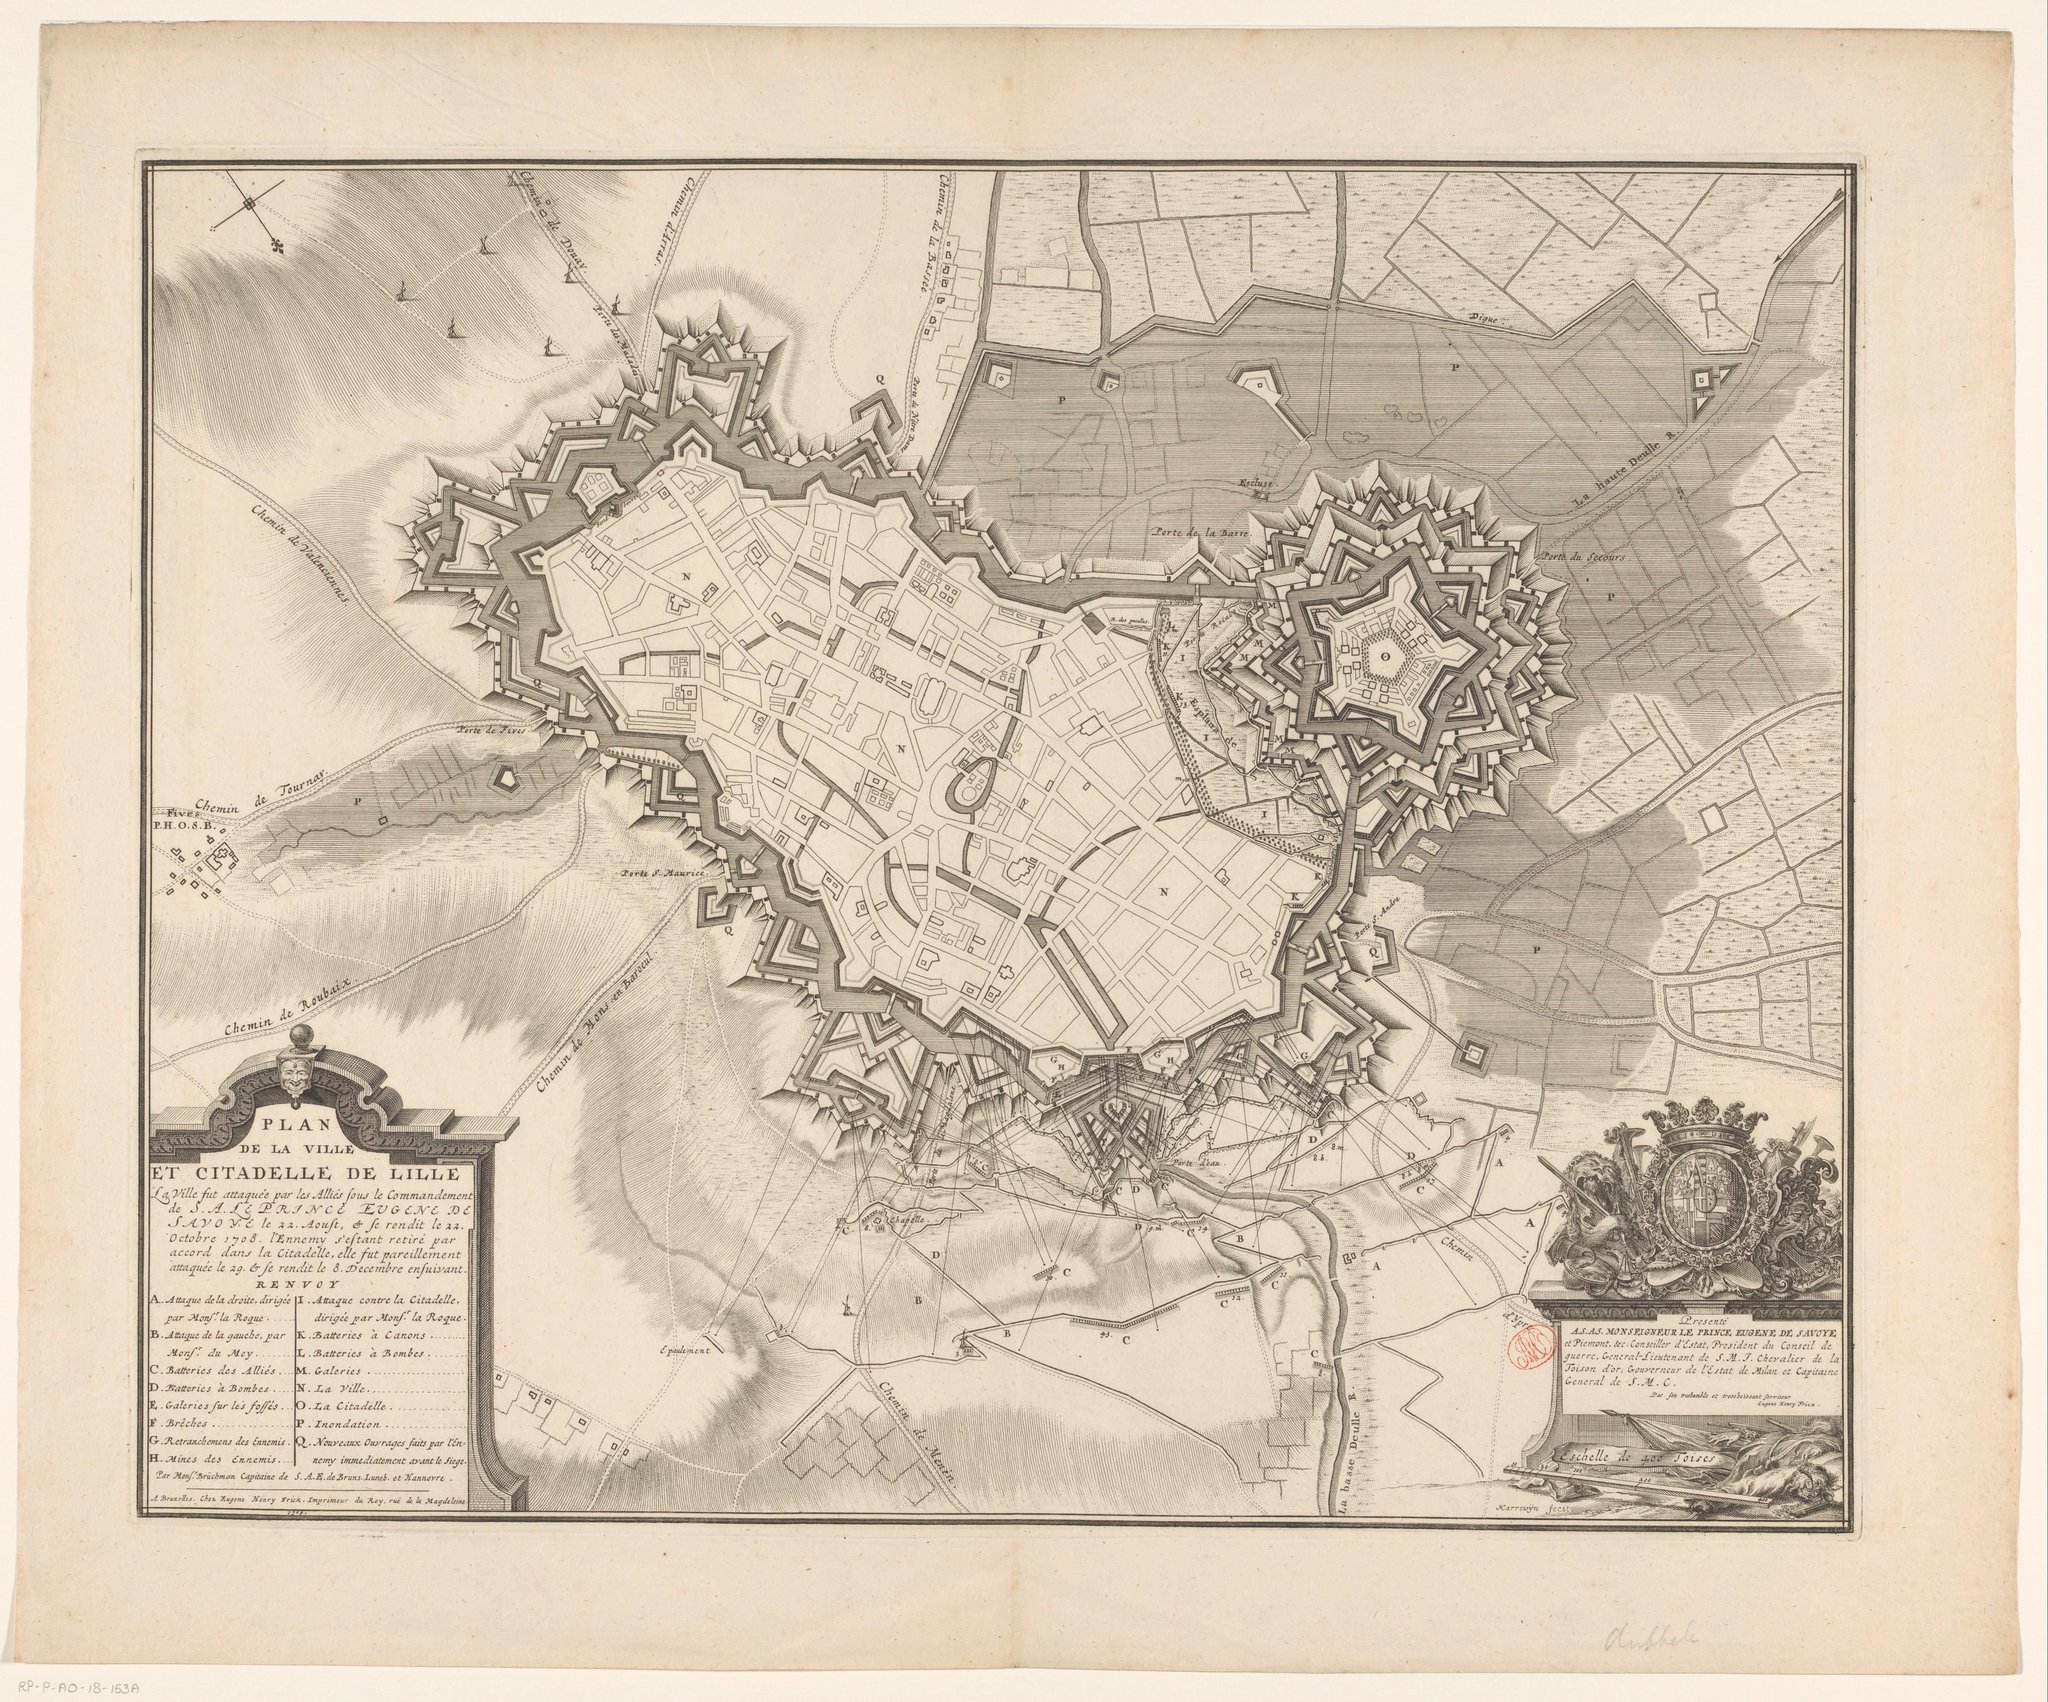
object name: print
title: Plattegrond van de versterkingen van Rijsel en de citadel, 1708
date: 1709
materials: paper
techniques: engraving, etching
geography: brussels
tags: paris, vienna, eugenius van savoye, siege, position war, maps of cities, armorial bearing, heraldry, lille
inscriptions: collector's mark: Lugt 2228, collector's mark: Lugt 195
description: Plattegrond van de versterkingen om de stad Rijsel (Lille) met de citadel, belegerd vanaf 22 augustus 1708 door de Geallieerden onder prins Eugenius van Savoye en ingenomen op 23 oktober, het kasteel werd op 8 december veroverd. Linksonder de titelcartouche met legenda A-Q. Rechtsonder een cartouche met de opdracht aan de prins van Savoye, zijn wapen en een schaalstok: Eschelle de 400 Toises.